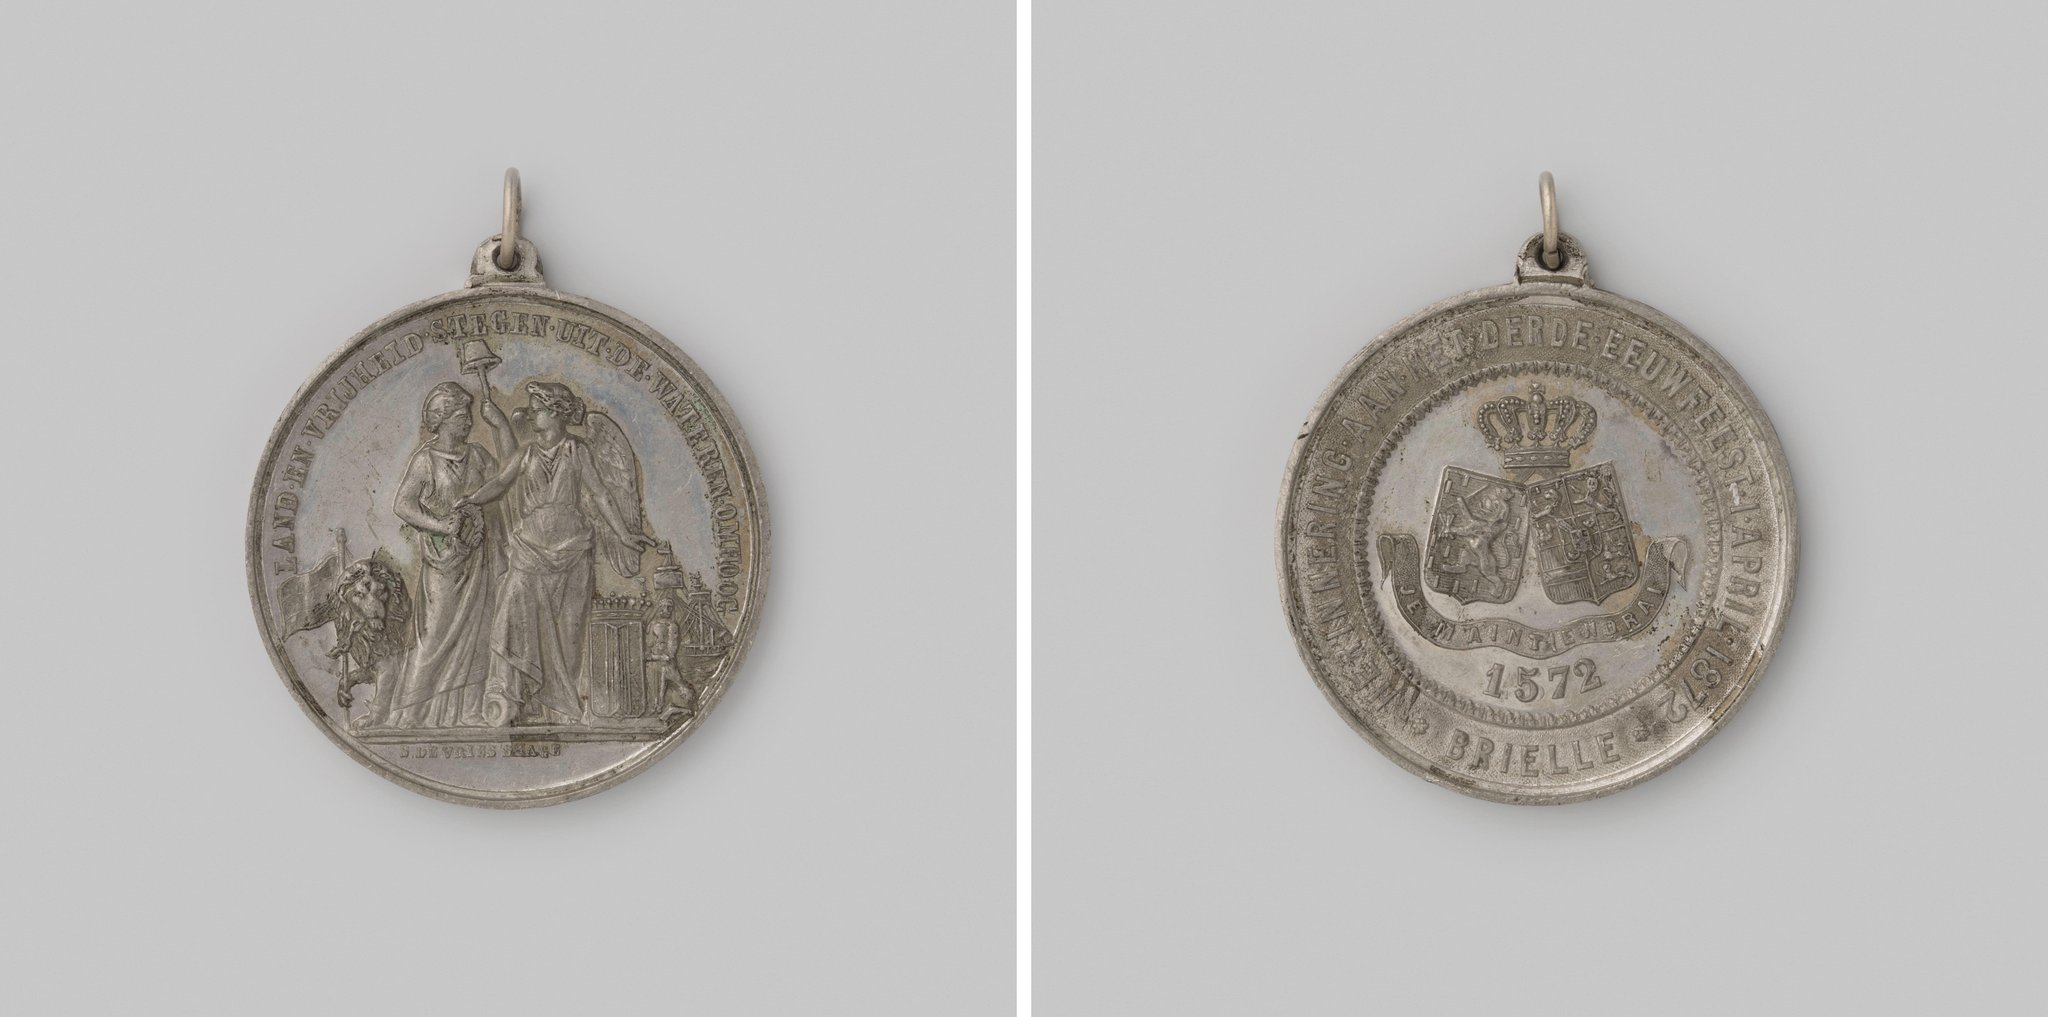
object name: history medal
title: Herdenking van de inname van Den Briel 1872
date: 1872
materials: tin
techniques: striking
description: Tinnen penning met oog en draagring: op de voorzijde de Nederlandse Maagd met lans met vrijheidshoed ontvangt een lauwerkrans van Victoria, links de Nederlandse Leeuw met vlag, rechts een watergeus en het Brielse wapenschild, met omschrift, op de keerzijde onder één kroon de wapenschilden van Nederland en Oranje, waaronder een tekstlint en het jaartal 1572, met omschrift.